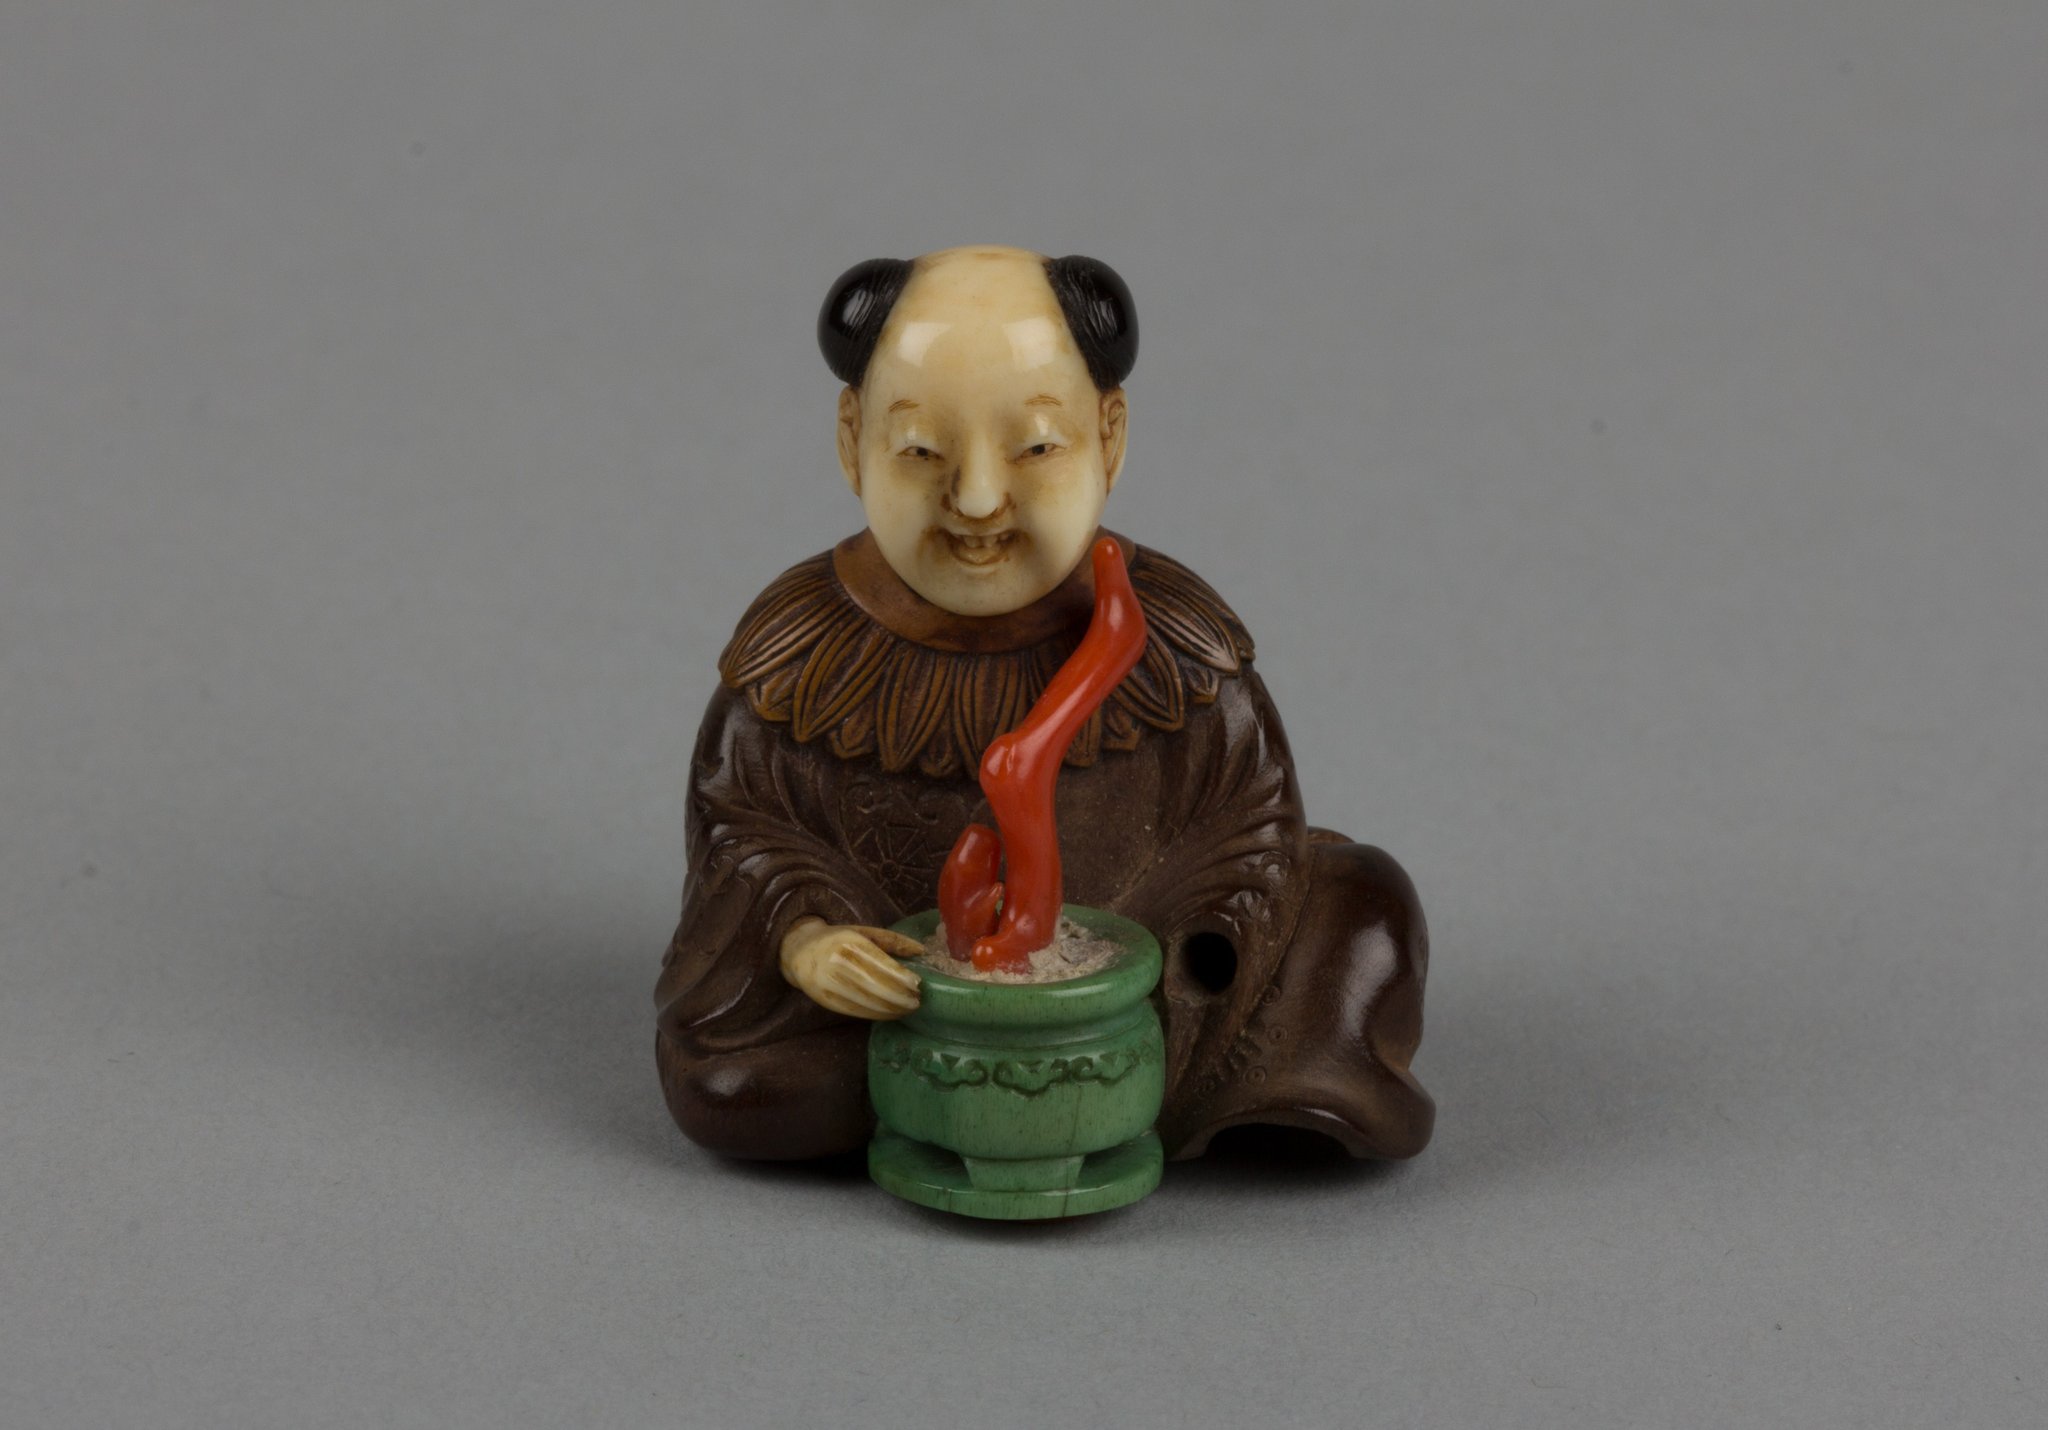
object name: netsuke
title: Netsuke of Seated Man with a Flower Pot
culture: japanese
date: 1801-1900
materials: ivory, wood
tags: men